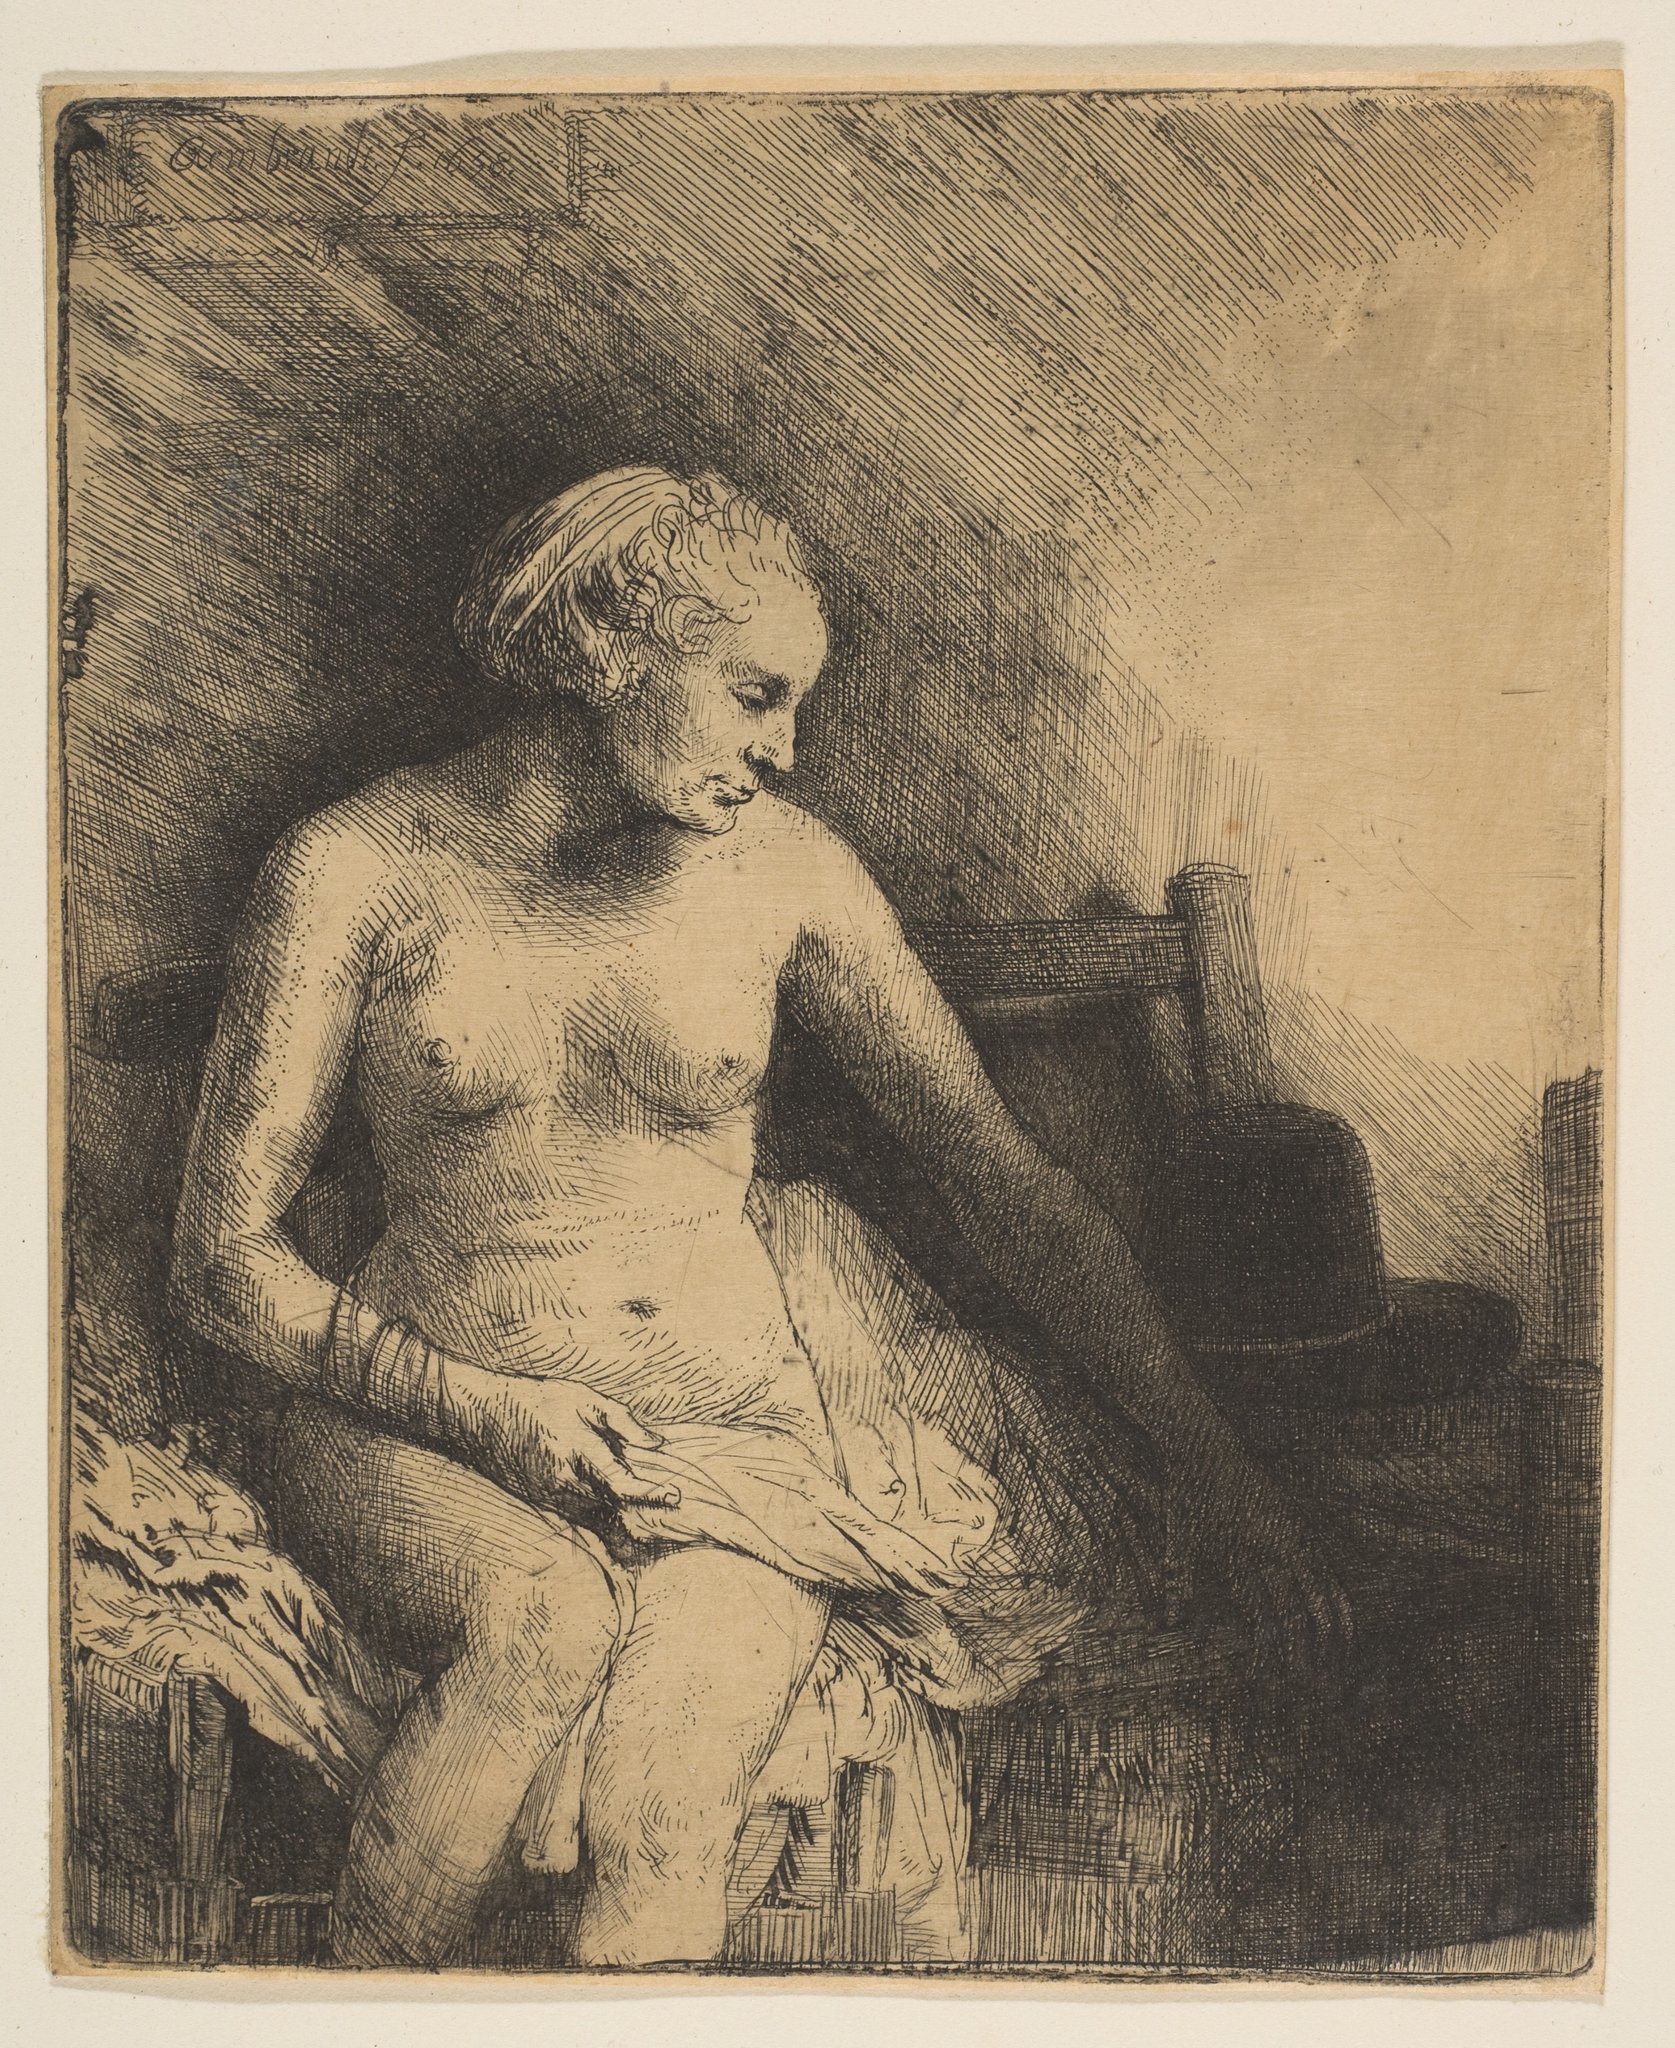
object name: print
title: Woman at the Bath with a Hat beside Her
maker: rembrandt van rijn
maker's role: artist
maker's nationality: dutch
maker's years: 1606-1669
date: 1658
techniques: drypoint, etching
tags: female nudes,bathing